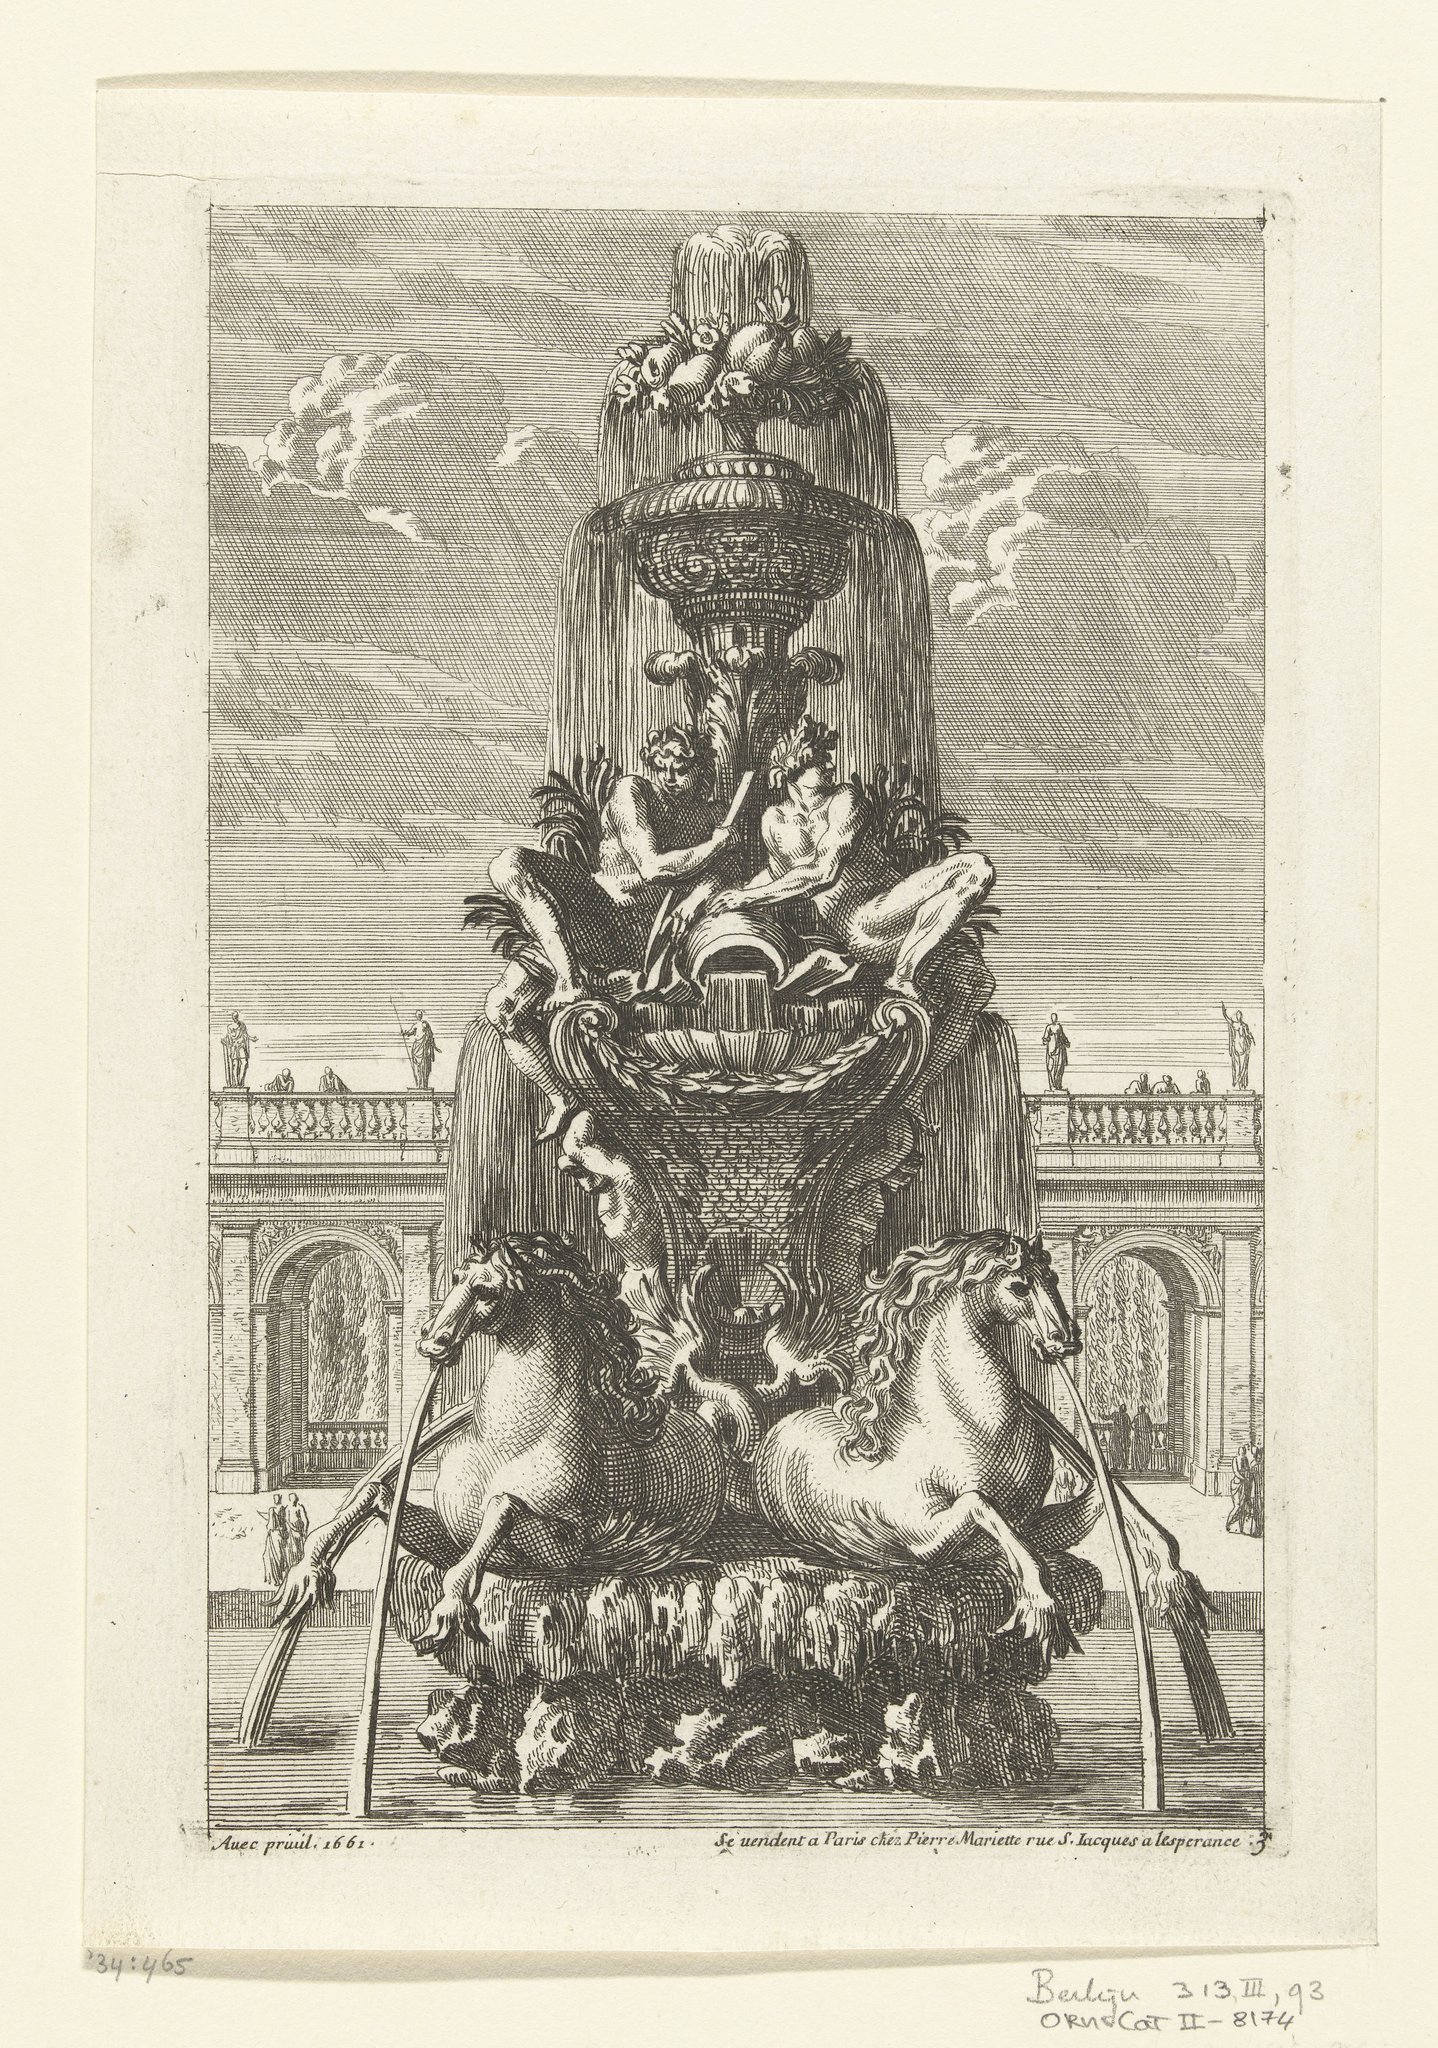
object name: ornament print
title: Fontaines, ou Jets d'Eau à l'italienne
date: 1661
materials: paper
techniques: etching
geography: paris